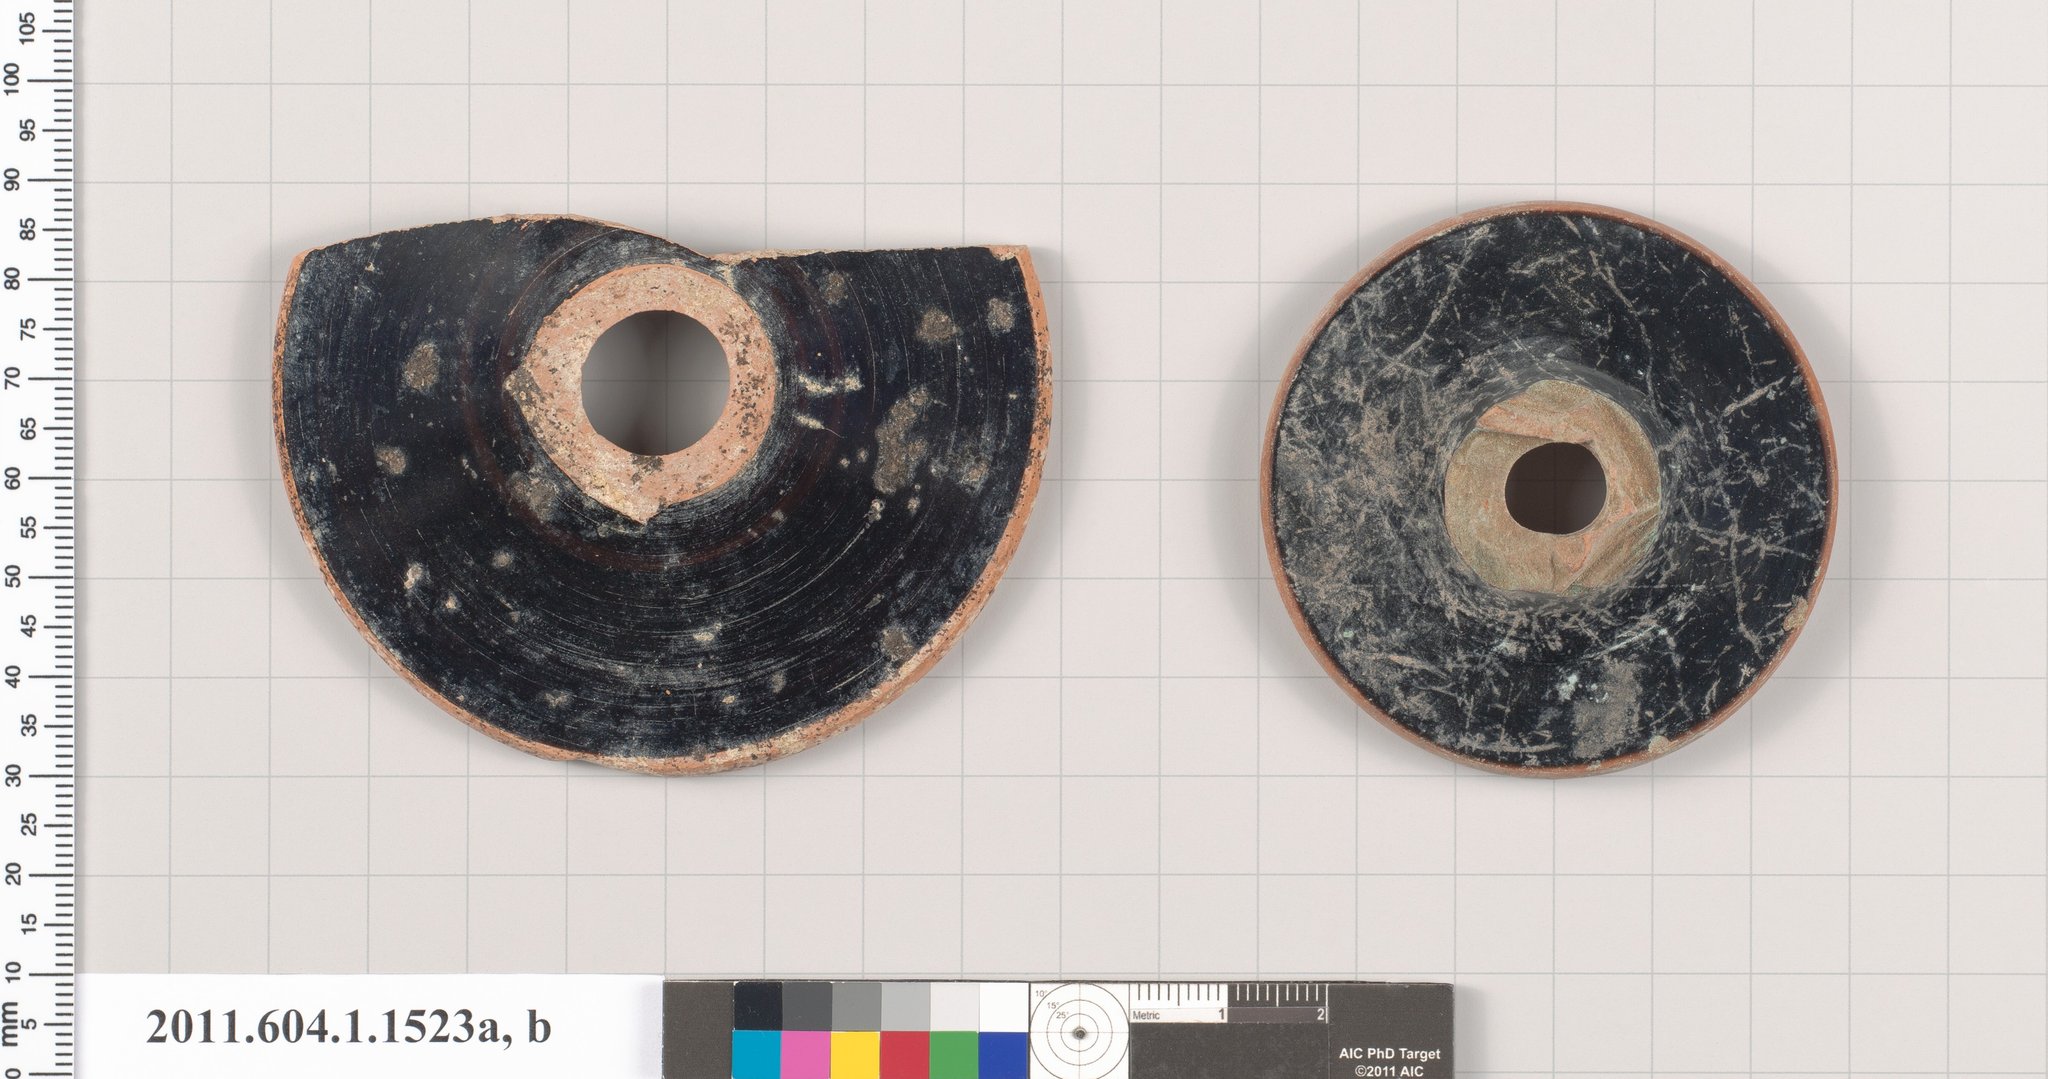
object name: kylix fragment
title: Terracotta fragments of kylikes (drinking cups)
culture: greek, attic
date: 500-401 BCE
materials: terracotta